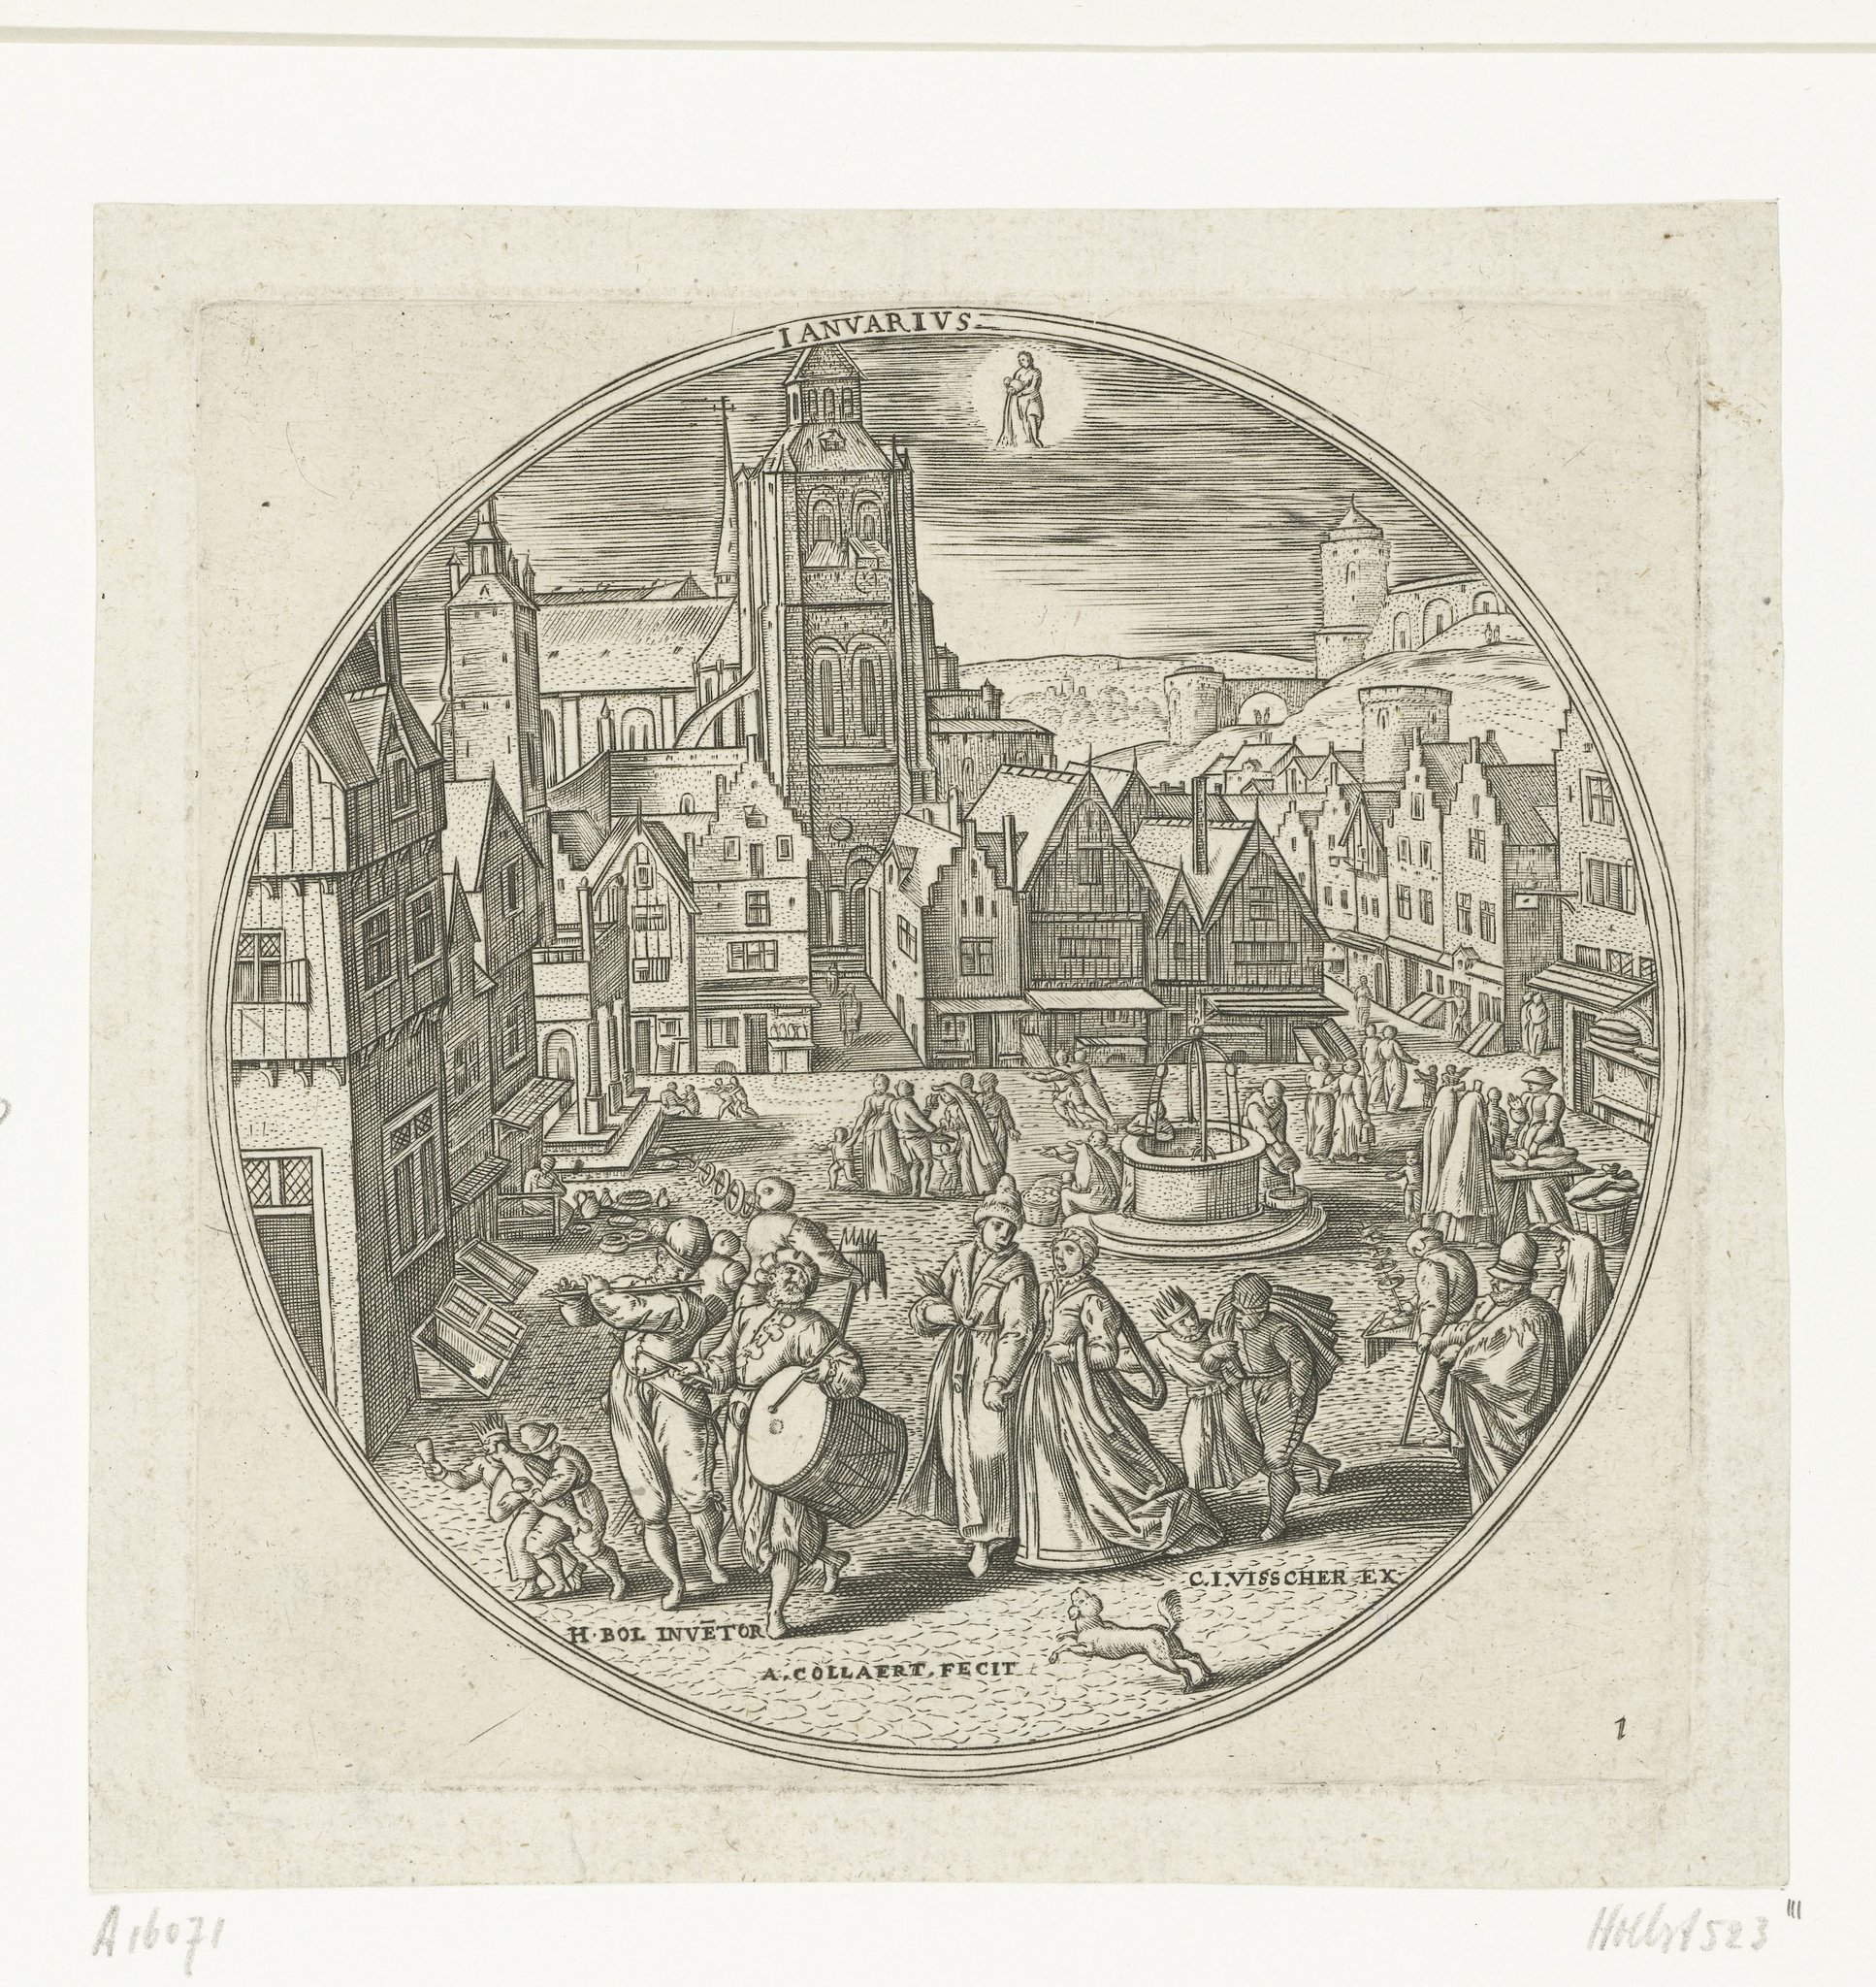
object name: print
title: De twaalf maanden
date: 1578-1582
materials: paper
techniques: engraving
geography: antwerp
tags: january and its 'labours', epiphany, square, place, circus, etc. (+ city(-scape) with figures, staffage), bergen op zoom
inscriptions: collector's mark: Lugt 2228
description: Ronde lijst met een wintertaferelen in de stad. Januari is de ijsmaand. Driekoningen wordt gevierd. Middenboven het sterrenbeeld Waterman. De prent is deel van een twaalfdelige serie over de twaalf maanden.